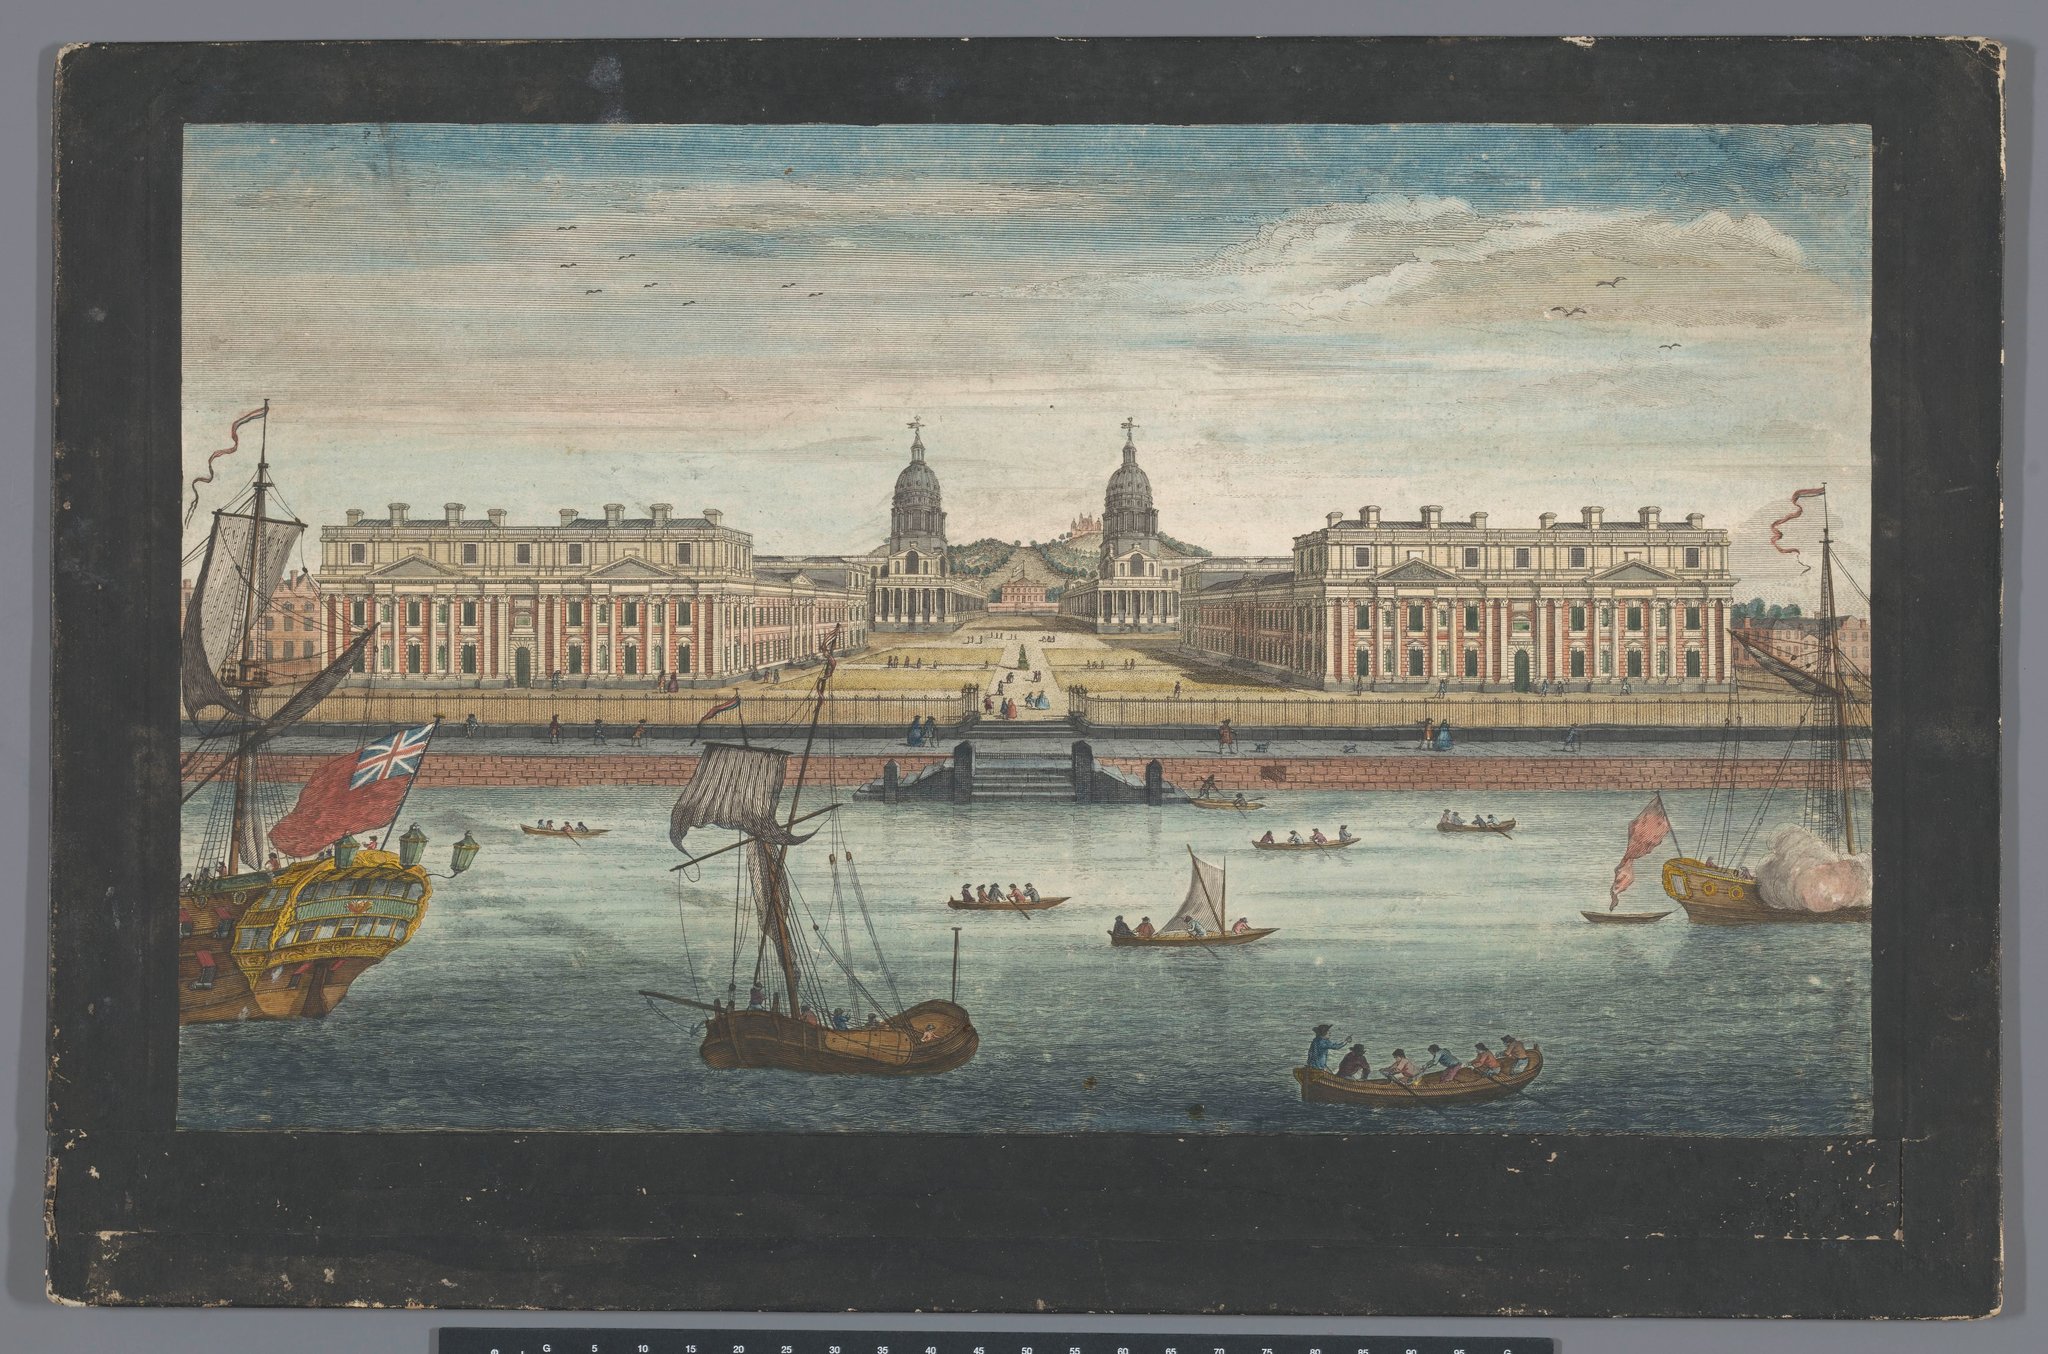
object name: opticaprent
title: Londen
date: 1751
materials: cardboard, paper, watercolor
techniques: brush, etching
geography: london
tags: sailing-ship, sailing-boat, rowing-boat, canoe, etc., hospital, canals, waters (in city) (+ city(-scape) with figures, staffage), thames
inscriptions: collector's mark: Lugt 2233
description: Mogelijk rechtsboven genummerd geweest: 9. De serie “Londen” bevat 52 prenten met de nummers 1-52, waarvan dit nummer 36 is.